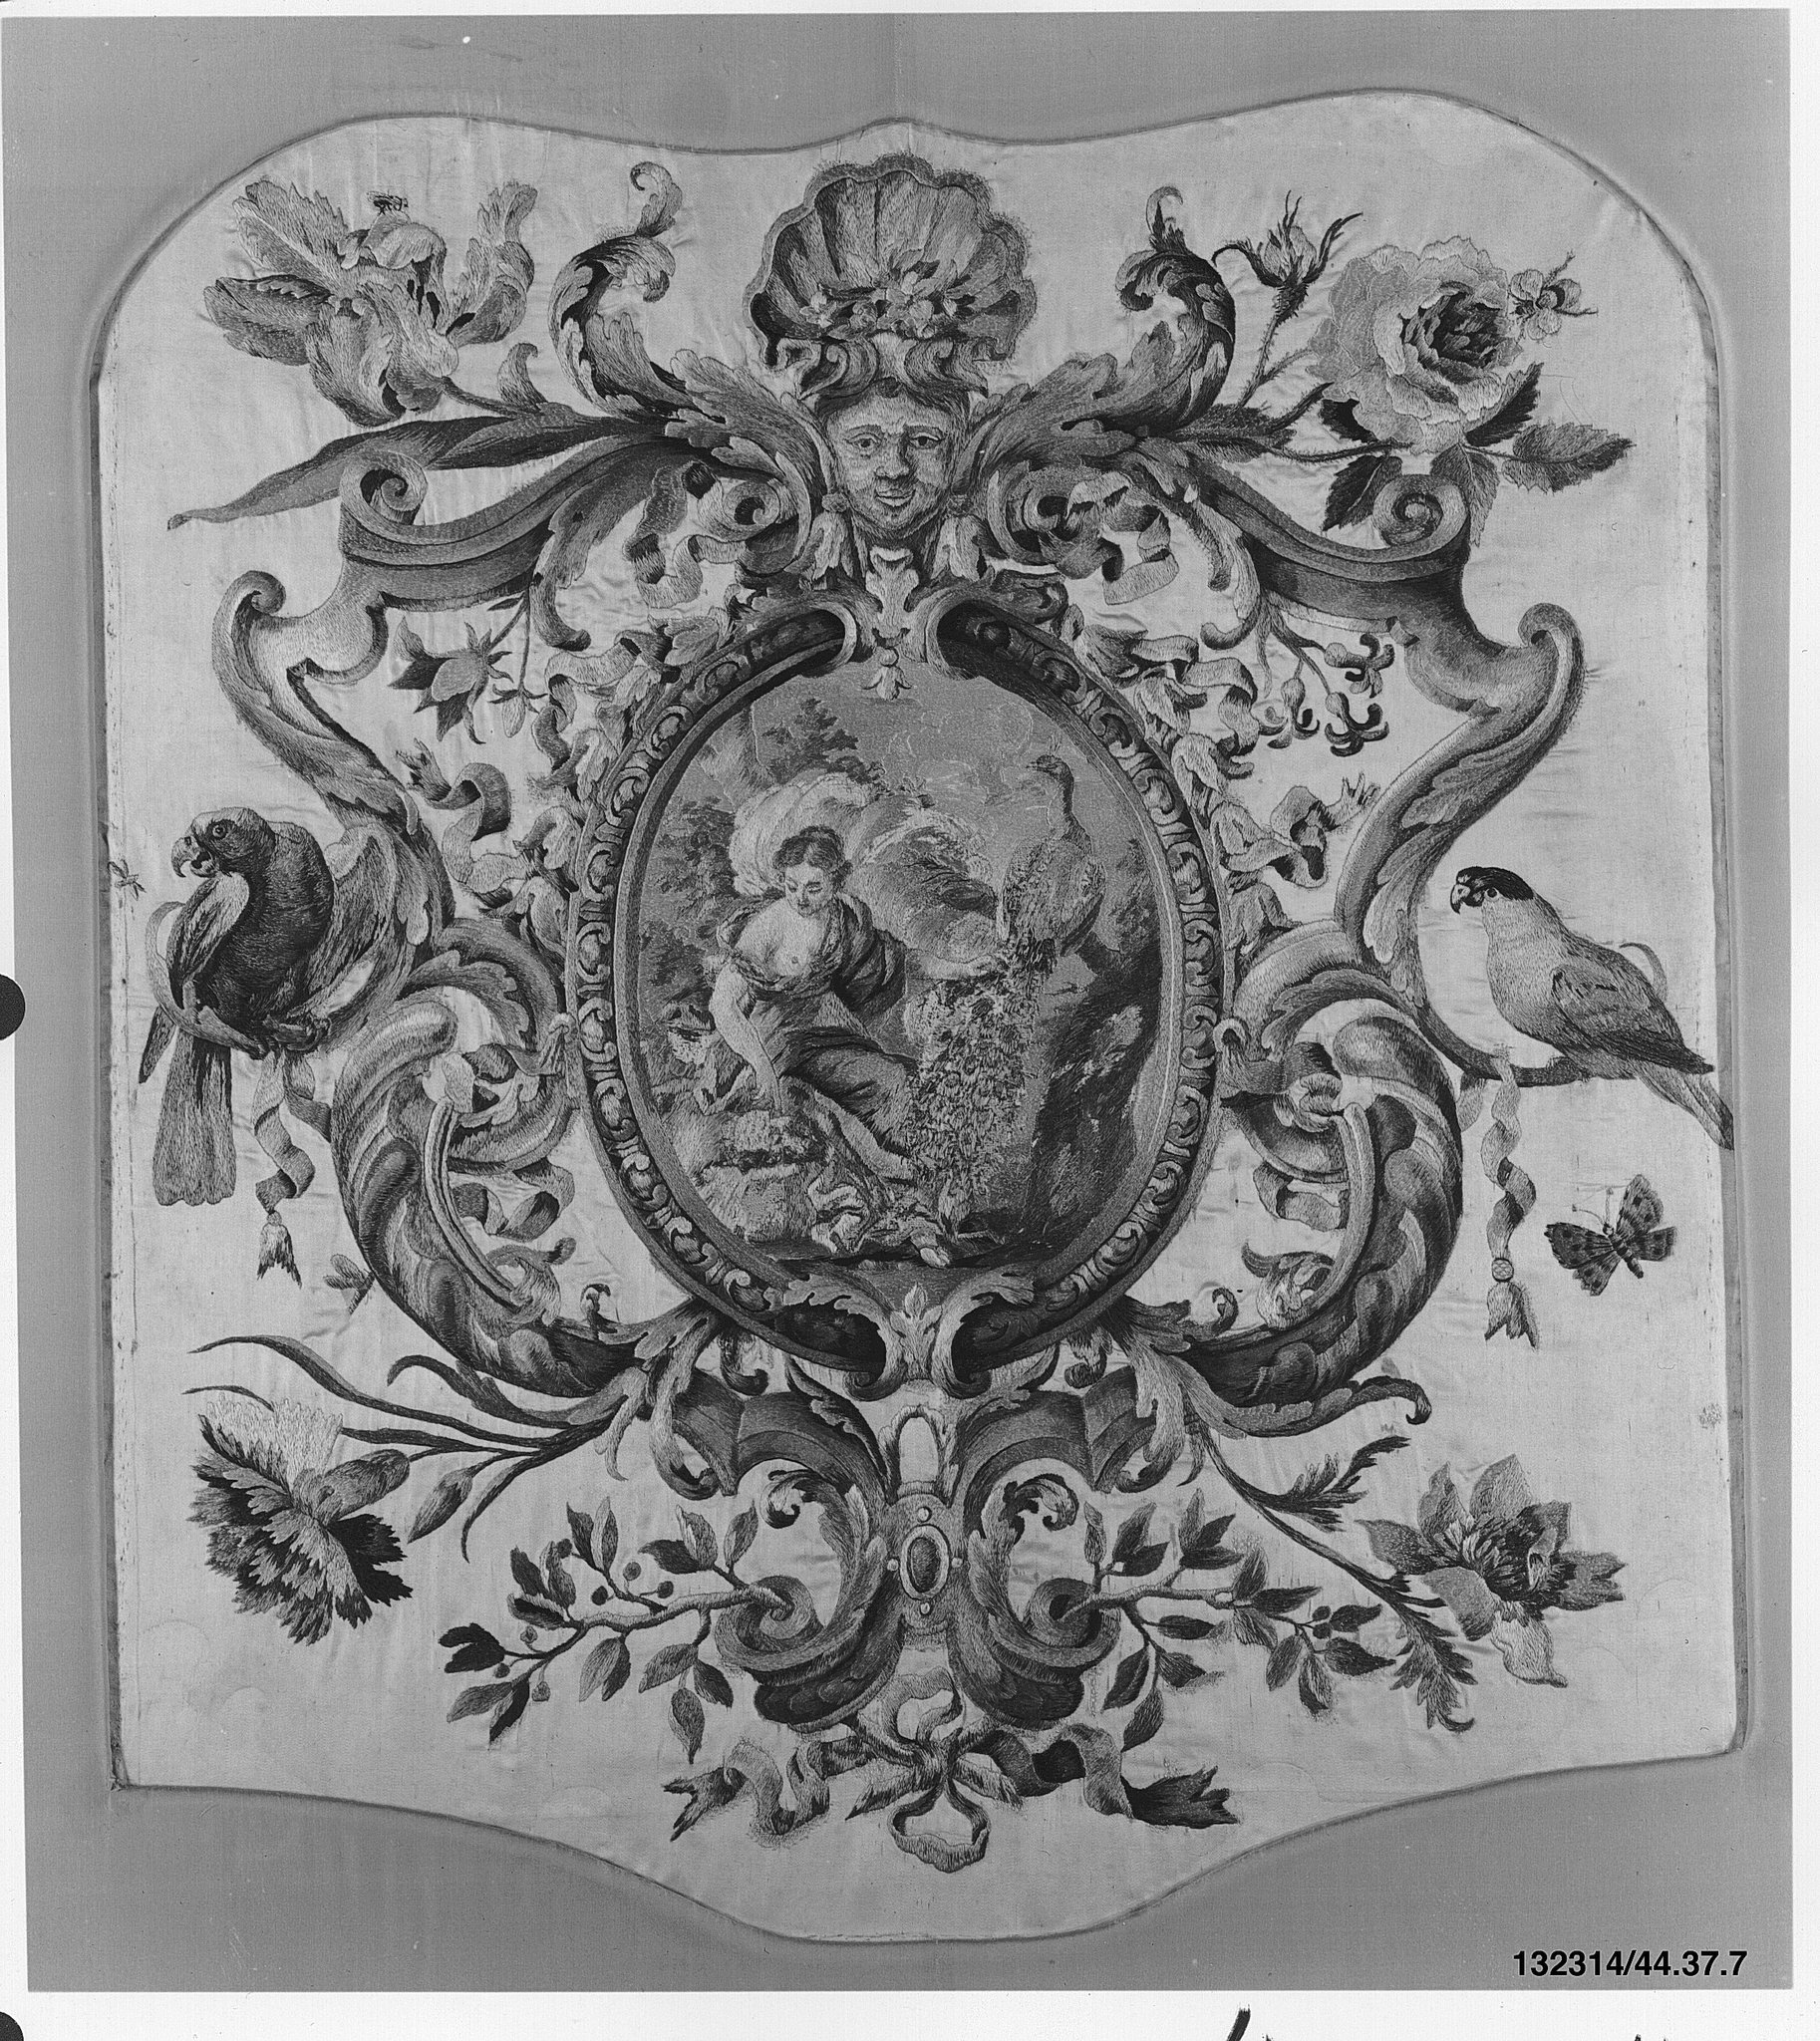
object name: upholstery panel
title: Chair panel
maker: daniel marot the elder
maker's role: maker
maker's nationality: french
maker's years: 1661-1752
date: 1701-1733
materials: silk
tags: birds,faces,women,flowers